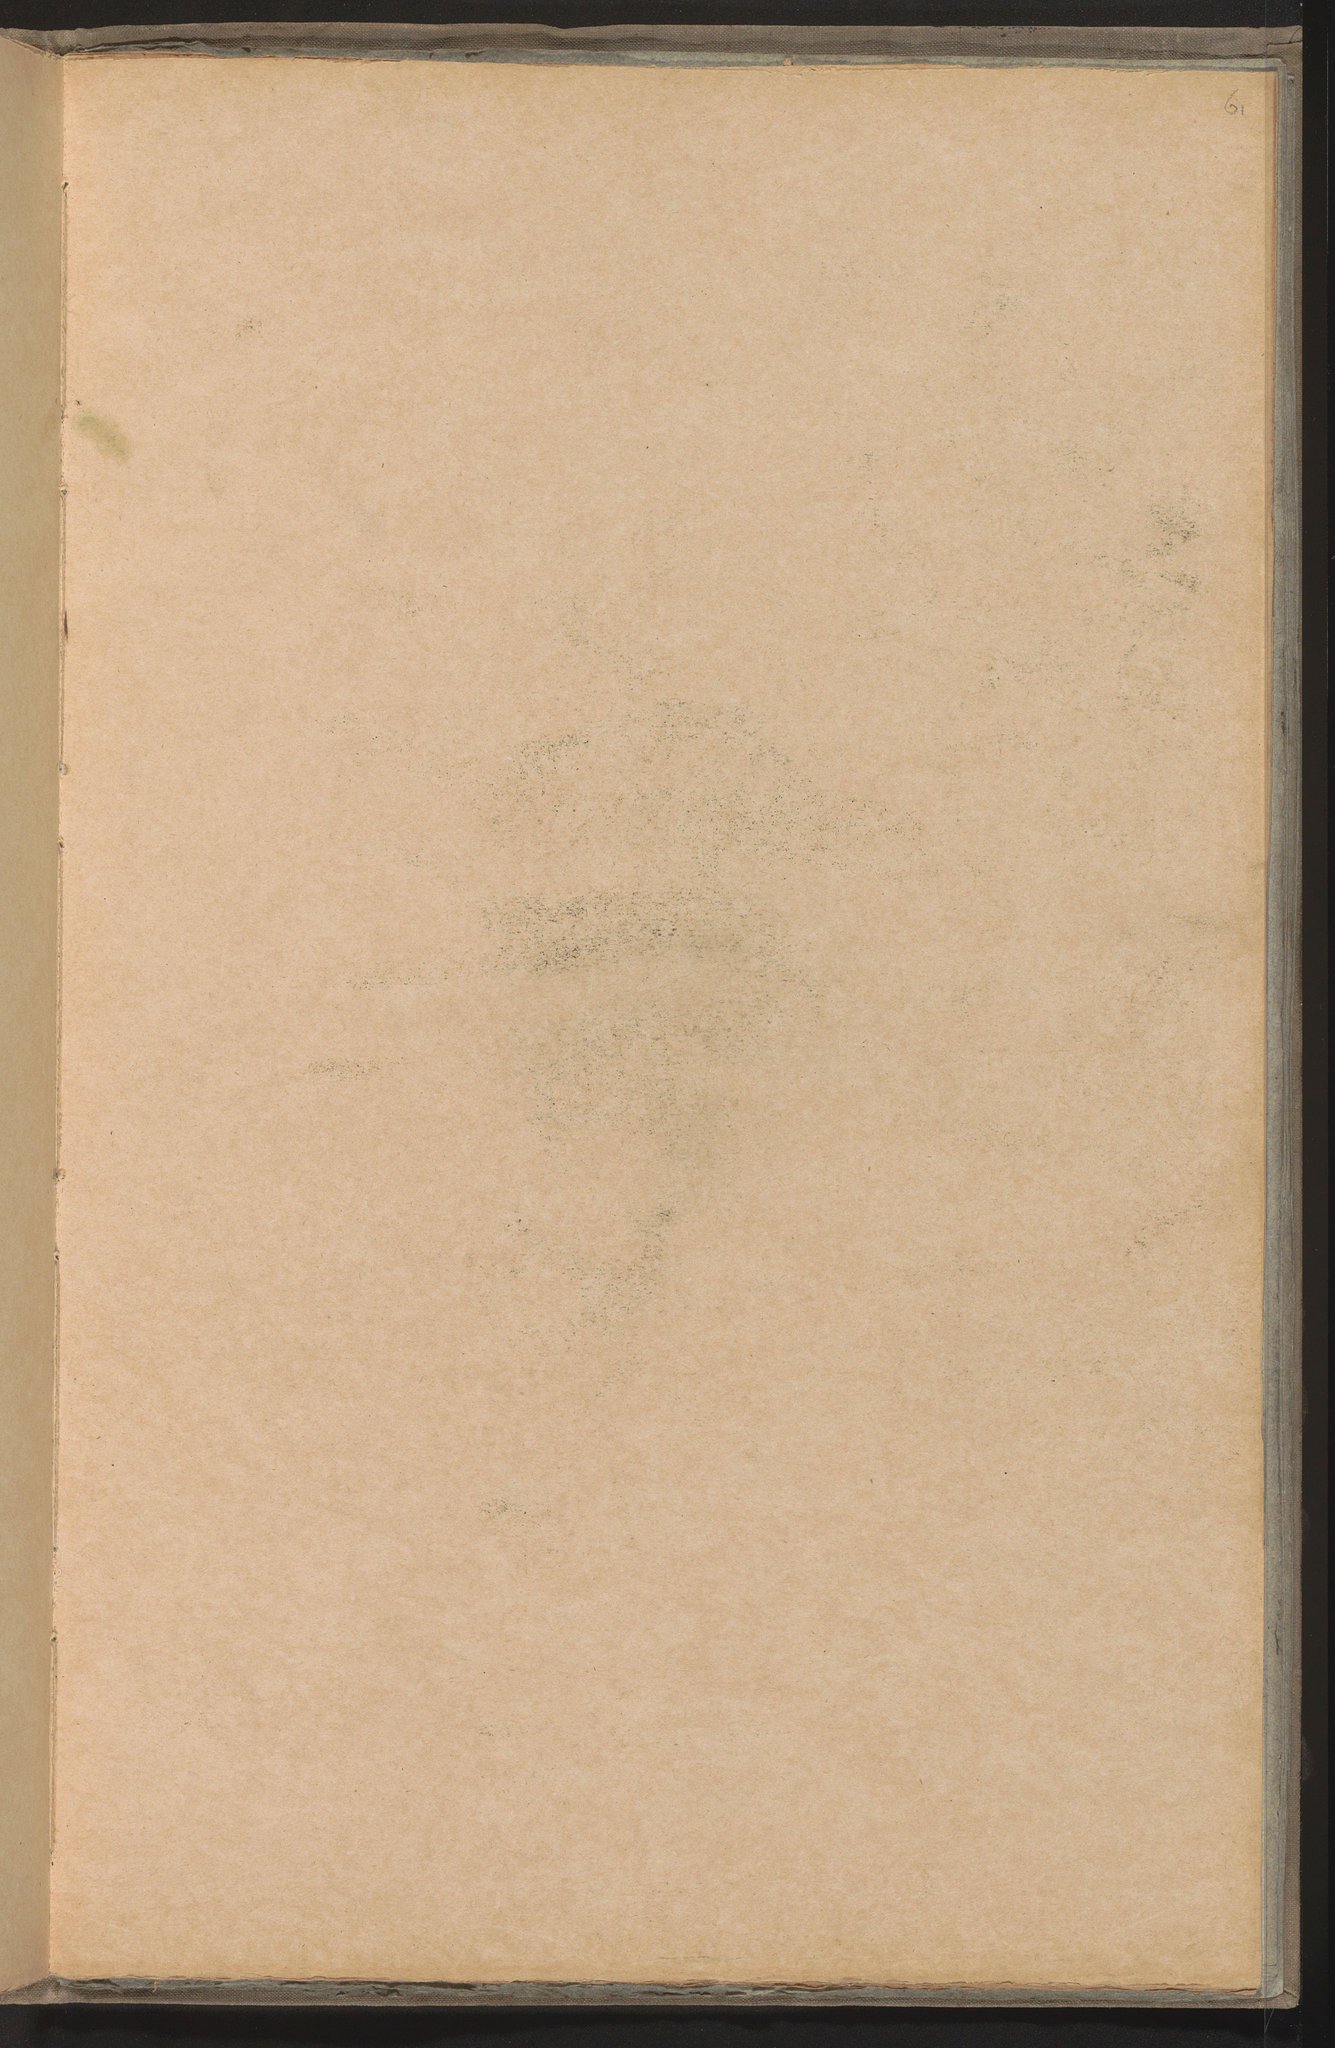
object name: sketchbook leaf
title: Abklatsch van een tekening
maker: willem witsen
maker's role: draughtsman, painter, print maker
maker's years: 1860-1923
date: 1884-1887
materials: paper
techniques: printmaking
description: Pagina 61 uit een schetsboek met 38 bladen.